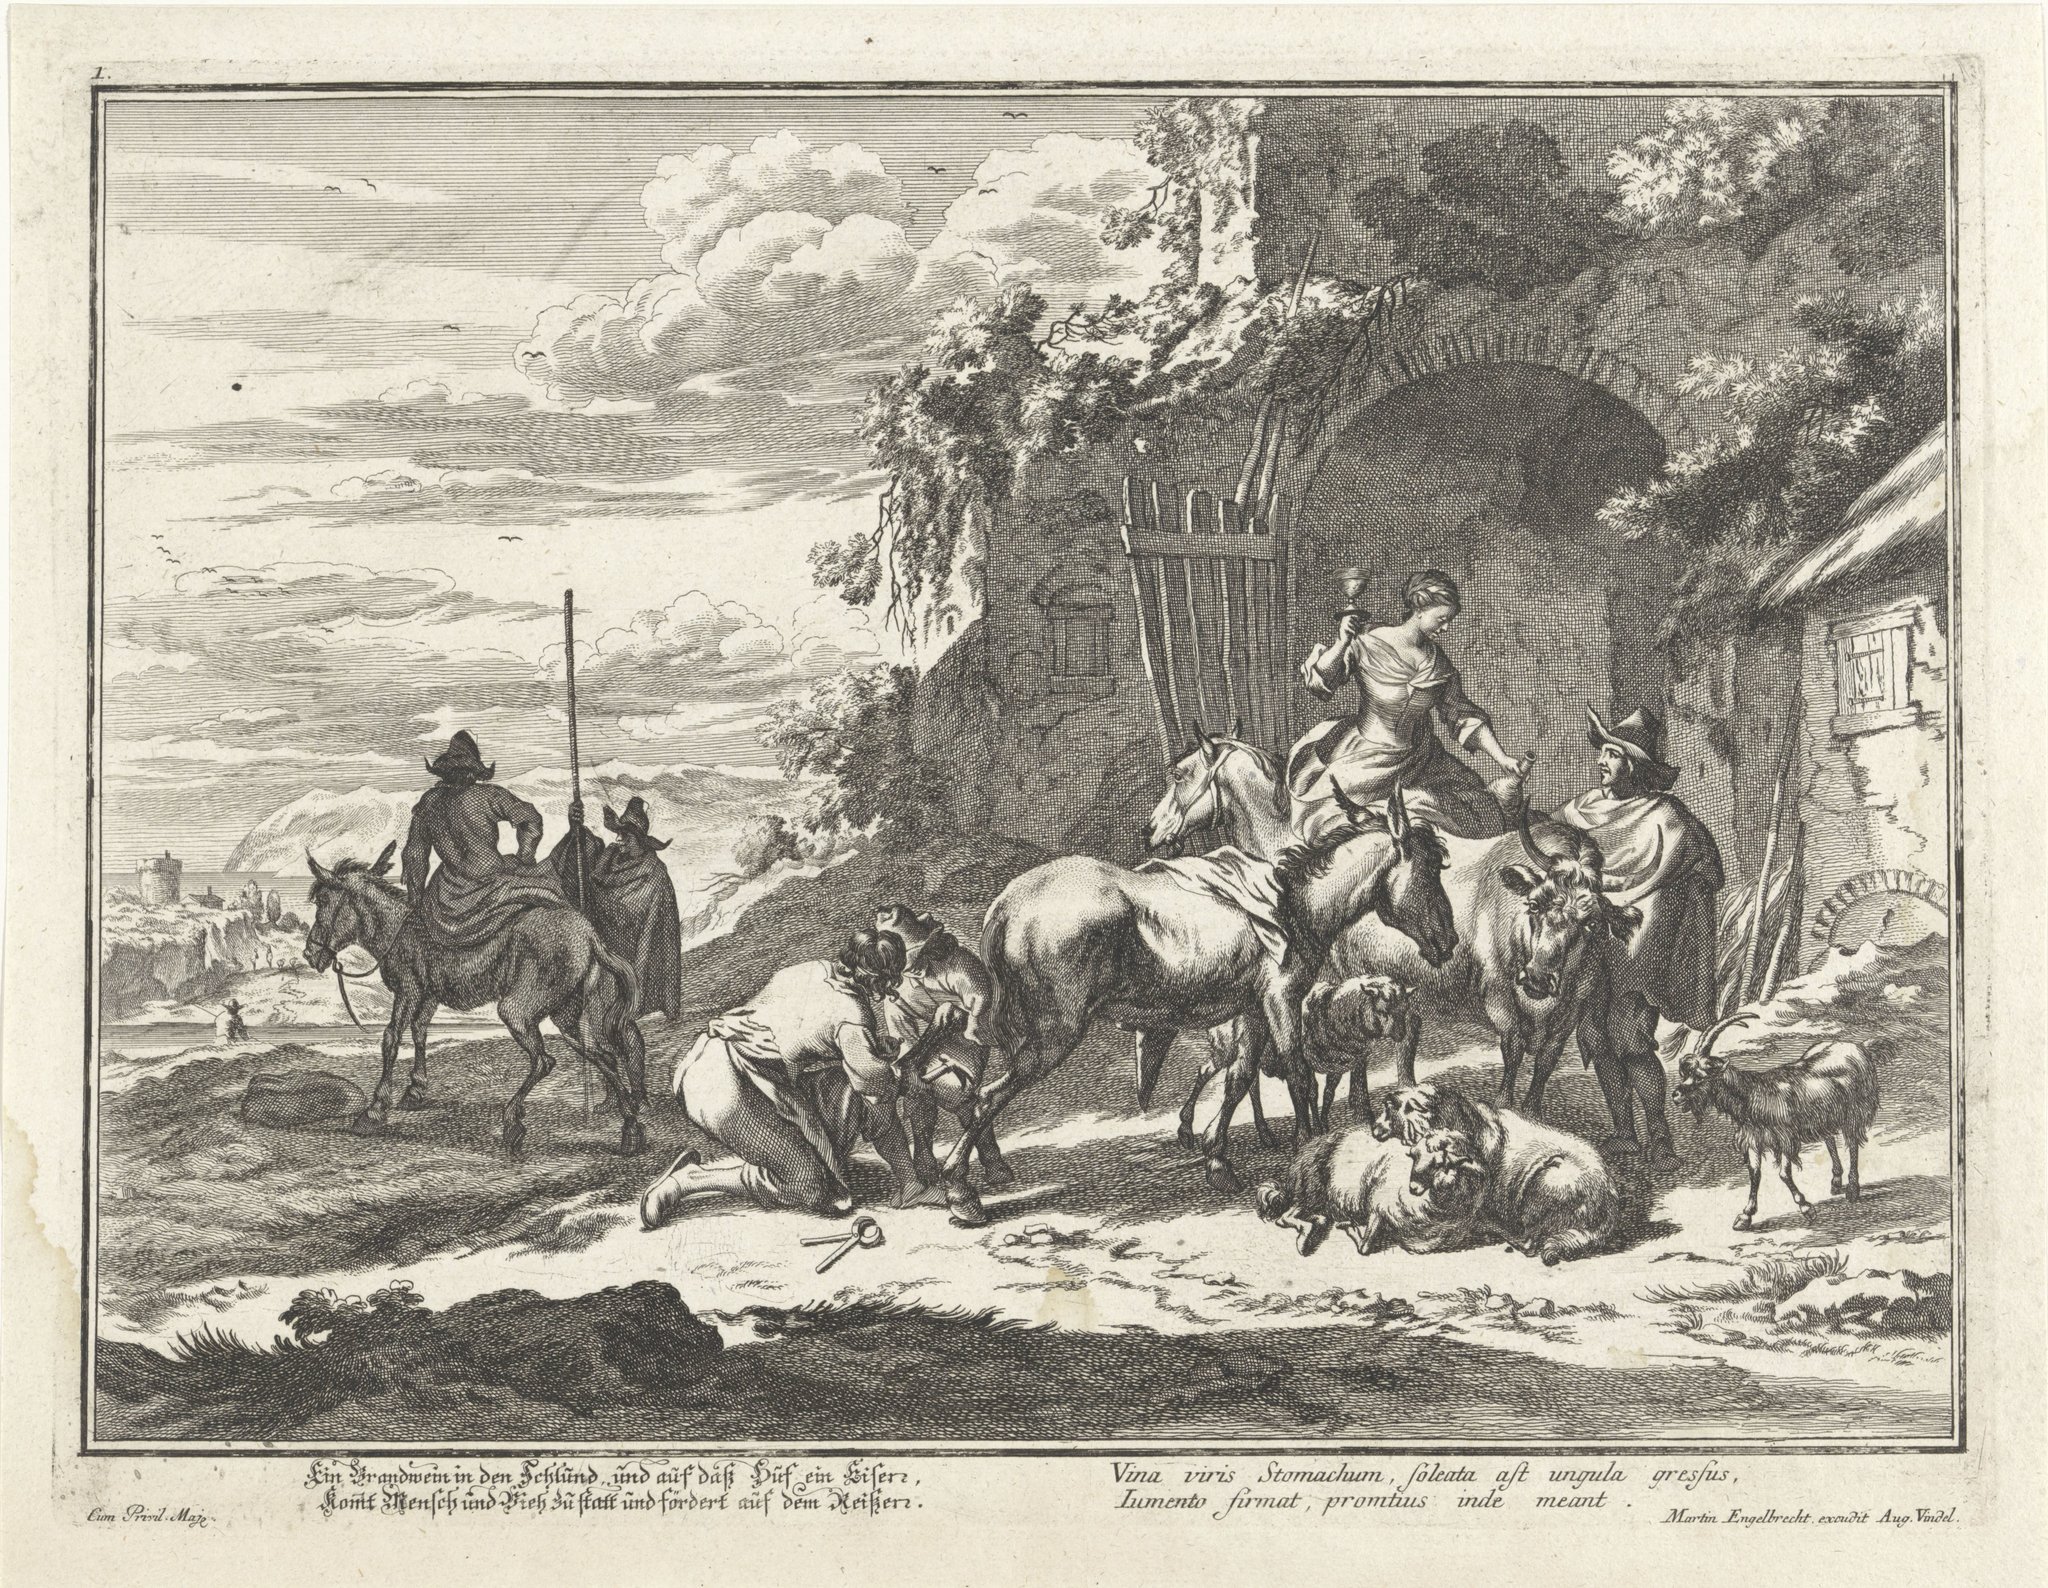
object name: print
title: Hoefsmid beslaat een ezel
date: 1699-1756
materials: paper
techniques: engraving, etching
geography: germany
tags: cow, landscapes, farrier, shoeing-smith, ass, donkey, herding, herdsman, herdswoman, shepherd, shepherdess, cowherd, etc.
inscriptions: collector's mark: Lugt 2228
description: In een bergachtig landschap voor een met planten begroeid gebouw beslaat een hoefsmid een ezel. Voor de ezel staan een koe en een paard. Op het paard zit een dame met een glas wijn.